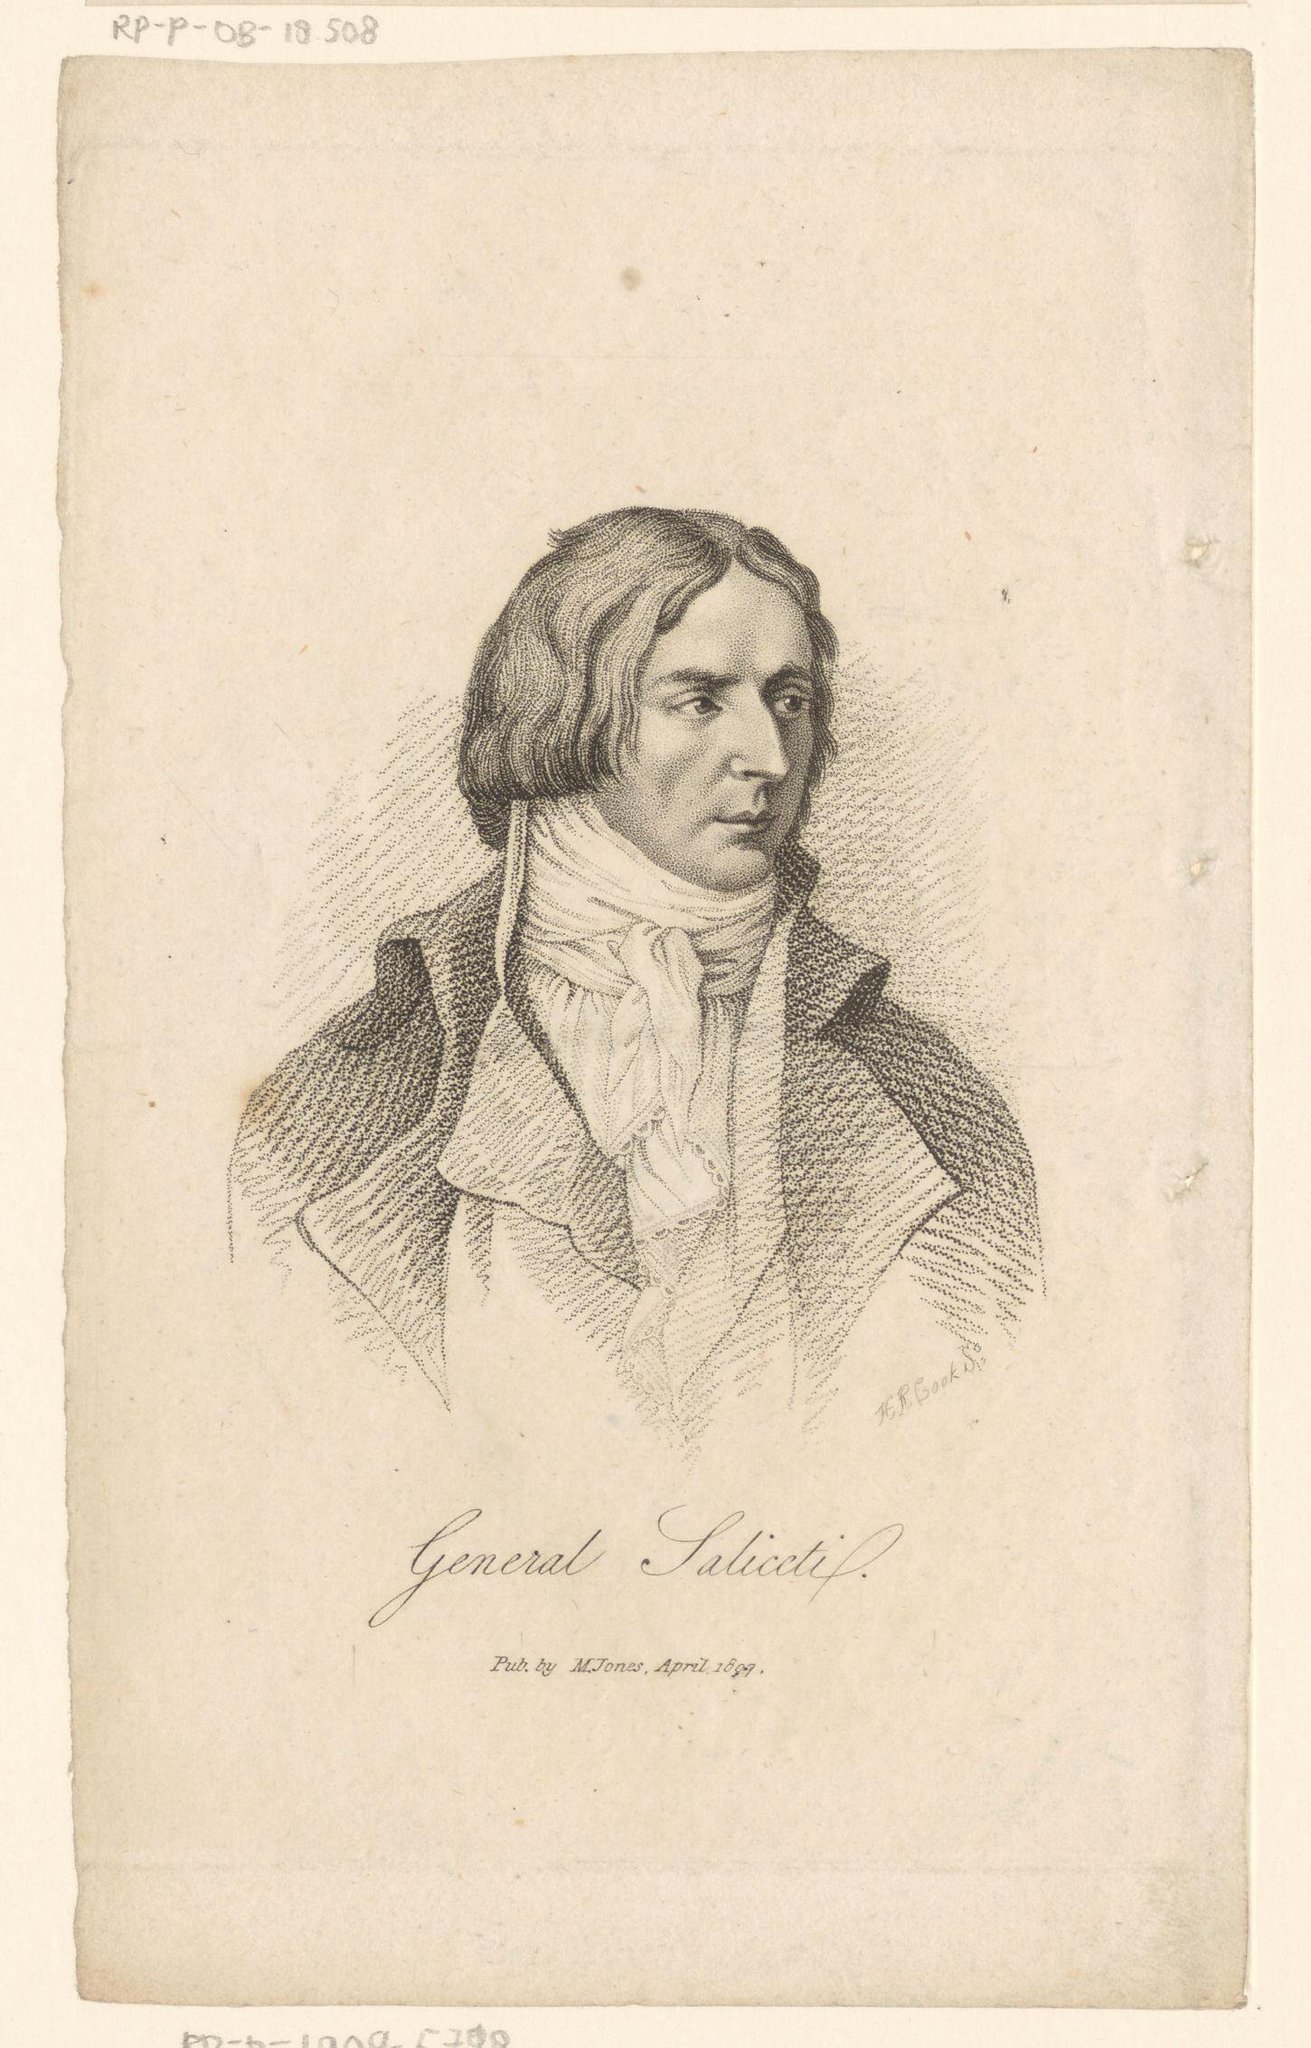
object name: print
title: Portret van Antoine Christophe Saliceti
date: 1804-1809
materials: paper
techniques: printmaking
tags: politician, historical persons, politician, e.g. party leader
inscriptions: collector's mark: Lugt 2228